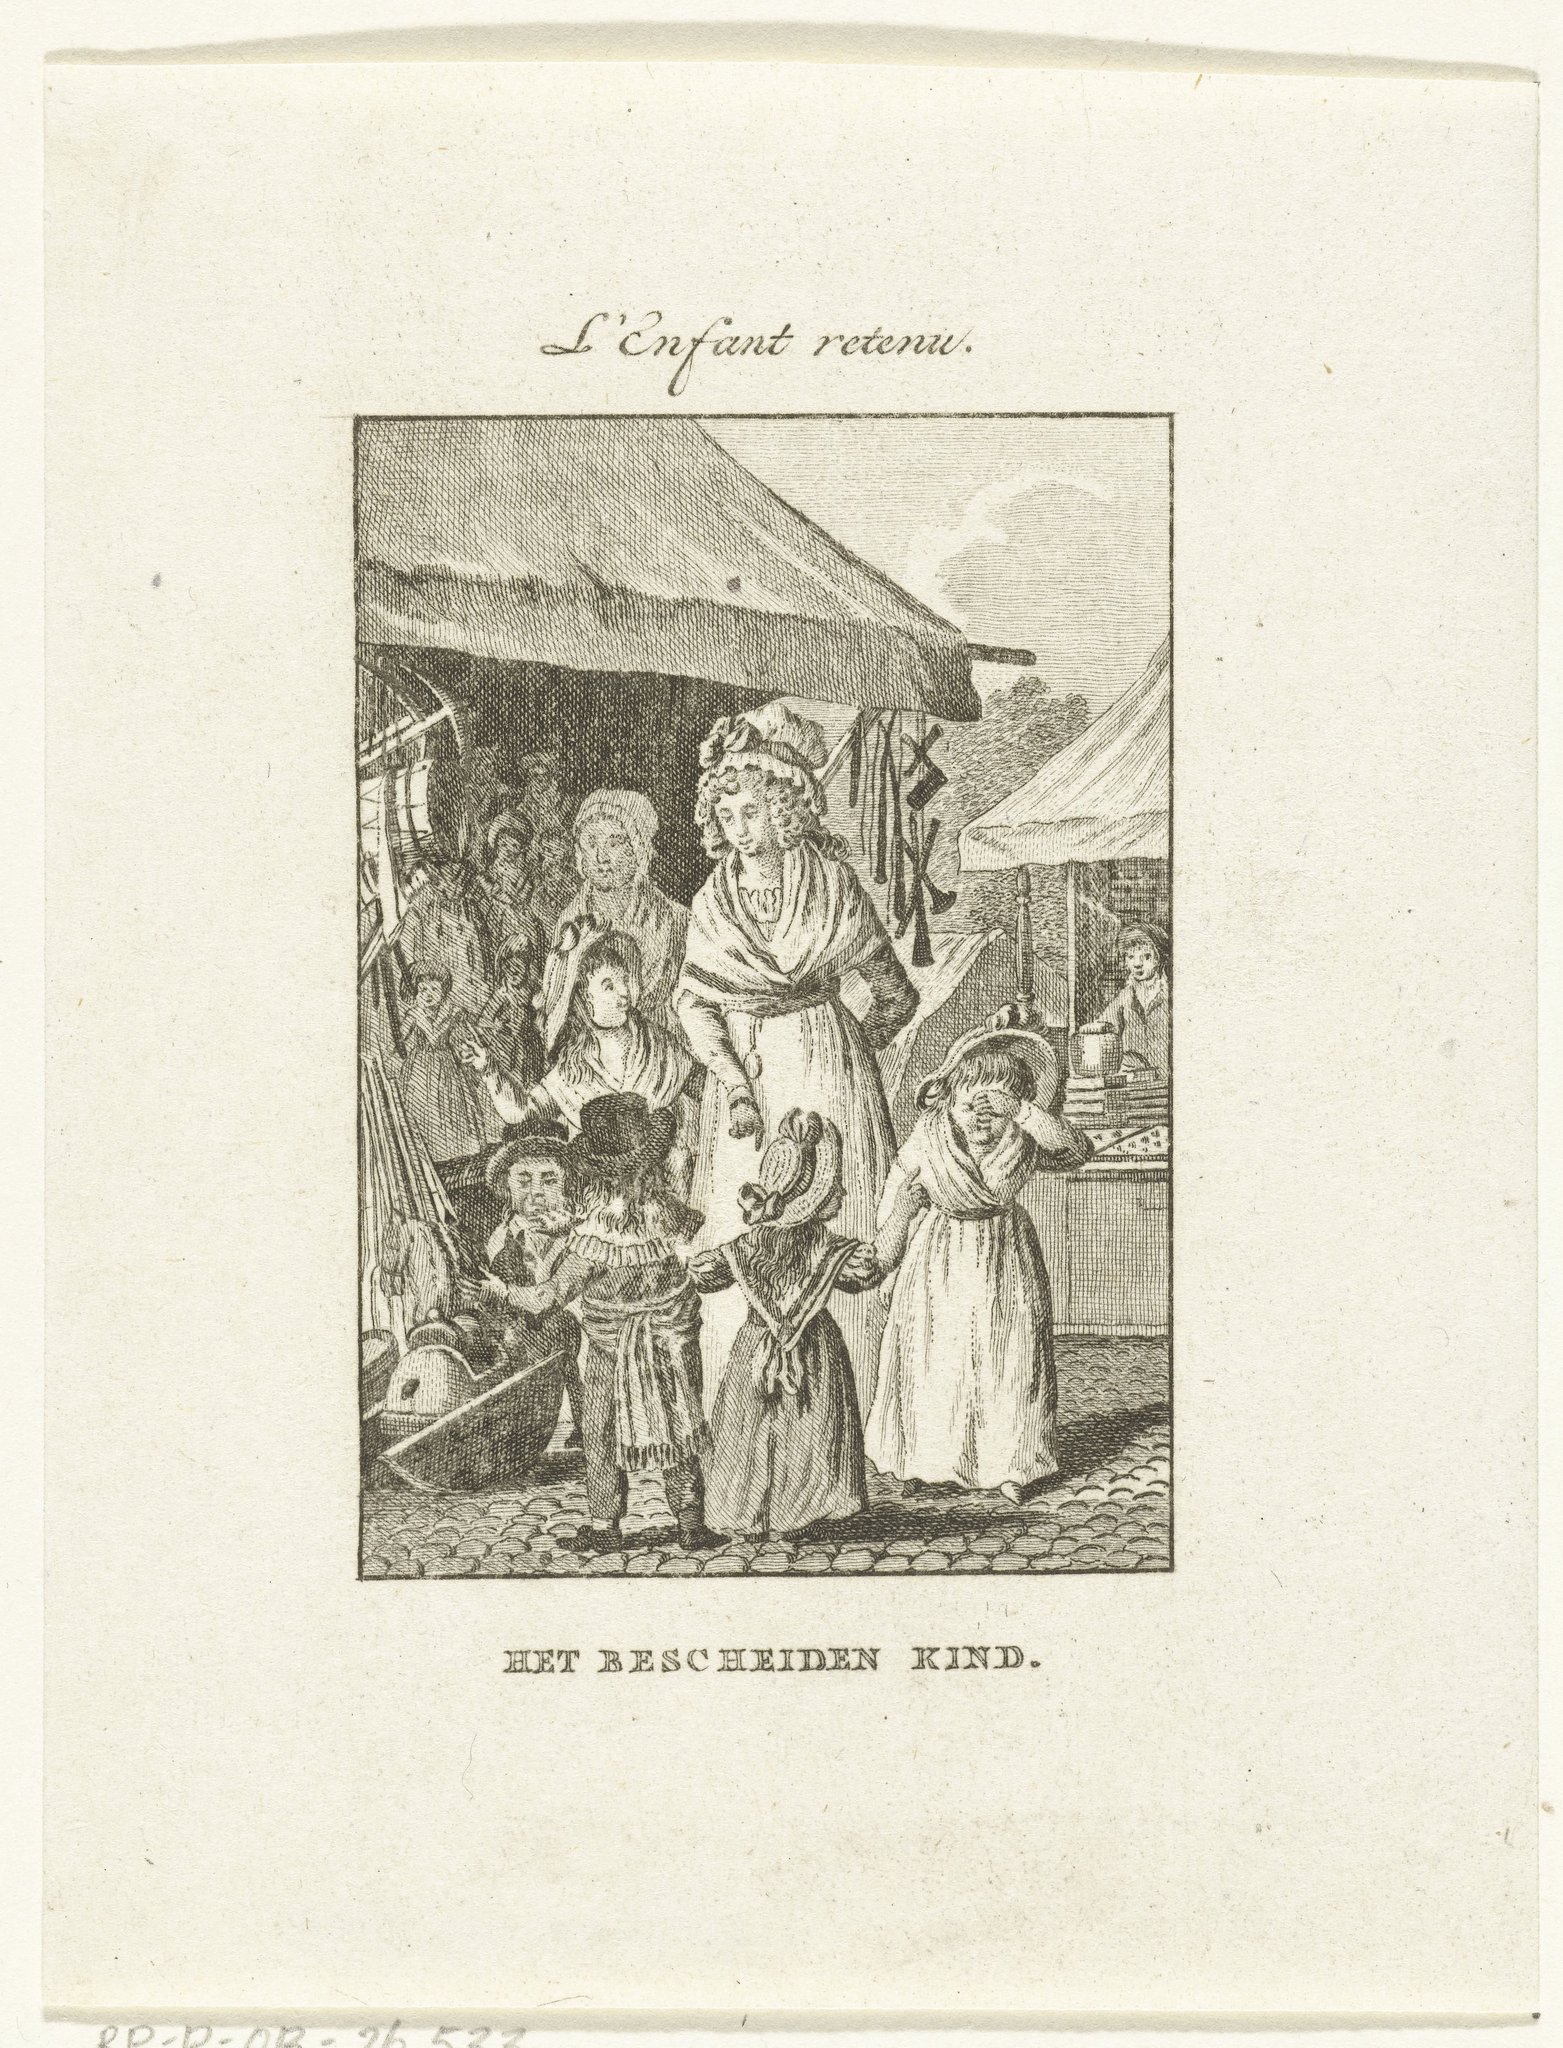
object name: print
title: Moeder met kinderen bij kraam met speelgoed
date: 1781-1799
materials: paper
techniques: etching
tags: (playing with) toys, mother and child(ren), woman and child(ren) (family group)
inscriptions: collector's mark: Lugt 2228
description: Prent uit: Aangenaam Kinderschool, wed. J. Dóll (uitgever), eerste druk, Amsterdam 1781. Mogelijk uit tweede, derde of vierde druk en op basis daarvan datering periode 1781-1799. Prent naar tekening van Isaac van Haastert.